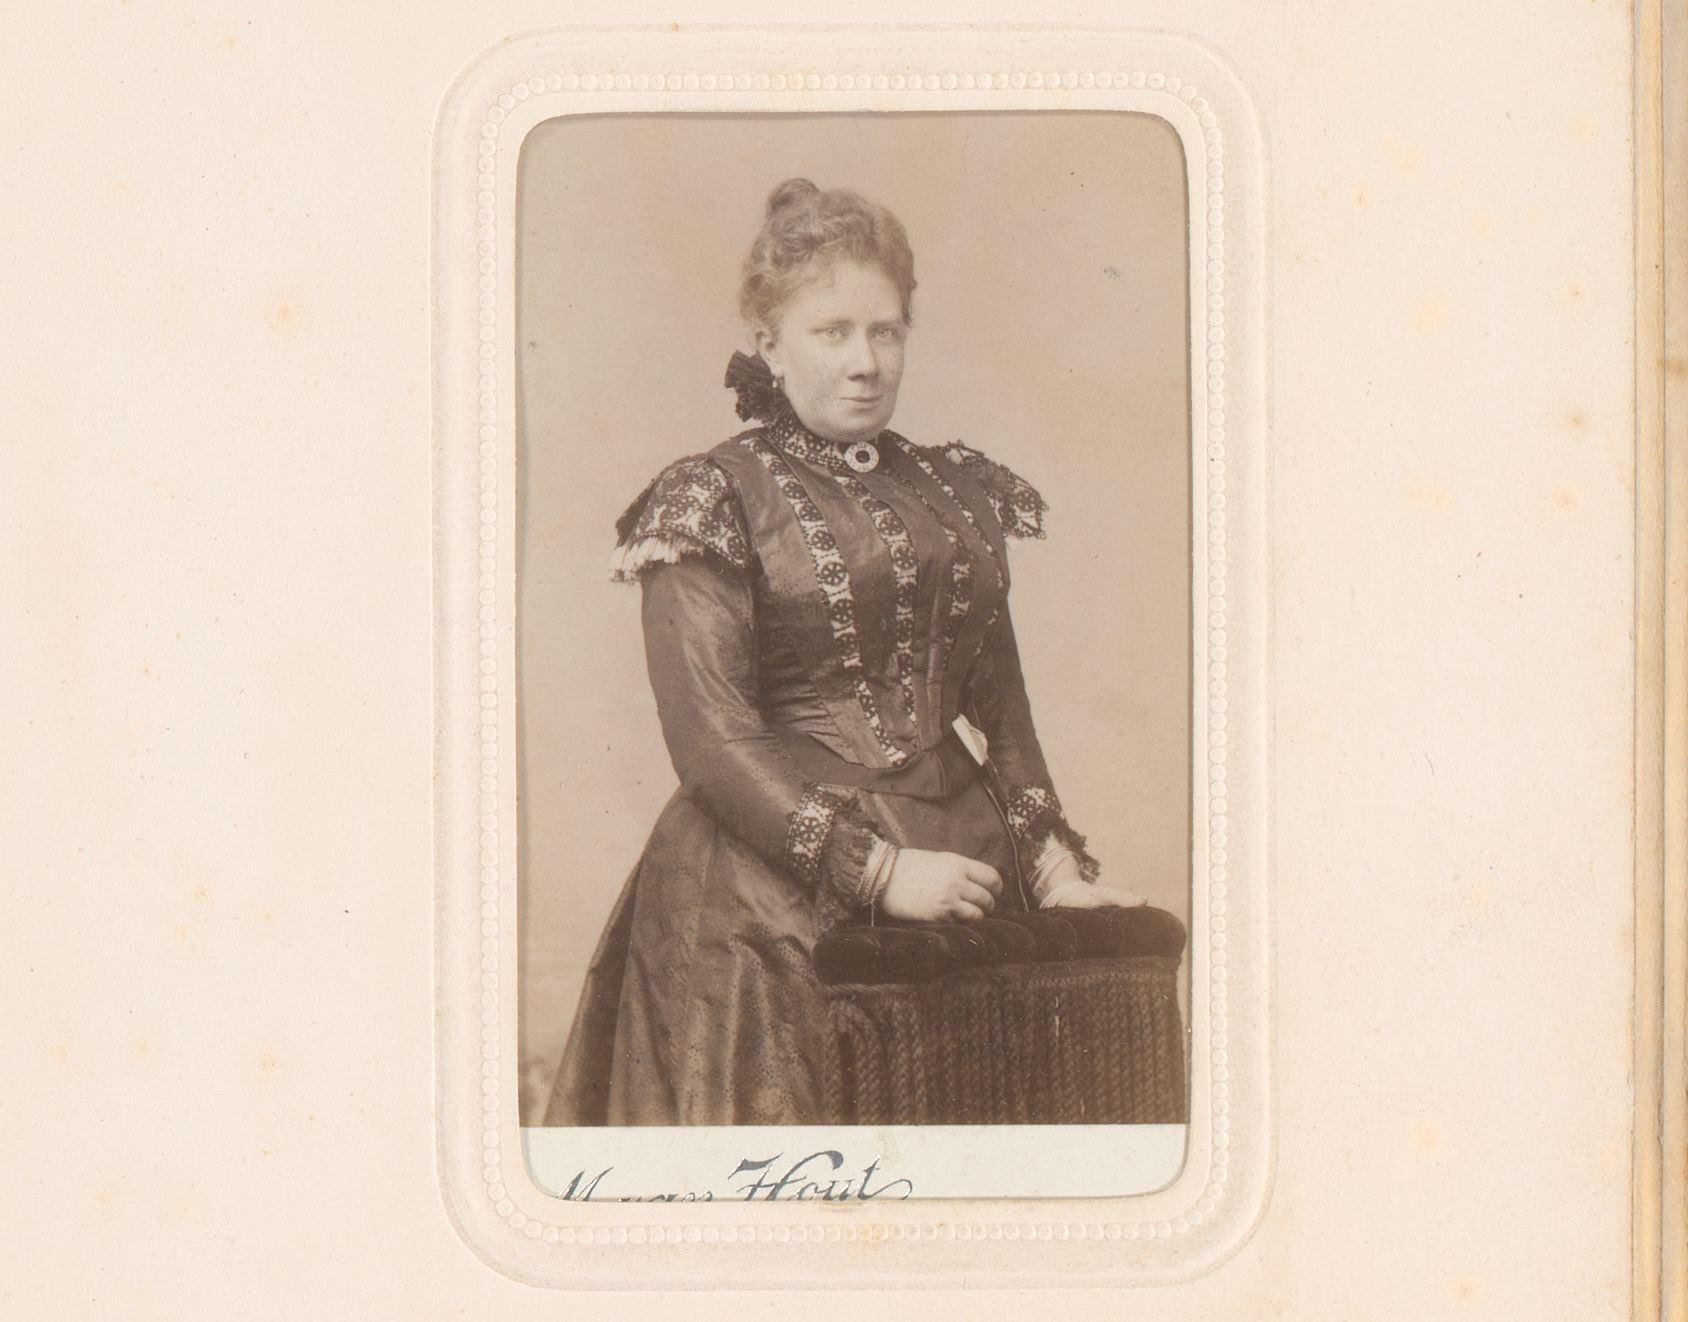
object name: album leaf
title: Portret van een staande vrouw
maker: matthieu van hout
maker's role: fotograaf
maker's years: 1857-1942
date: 1870-1900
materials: cardboard, photographic support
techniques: albumen print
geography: nijmegen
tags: historical persons - bb - woman, standing figure - aa - female human figure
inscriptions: inscription: ‘Nijmegen’